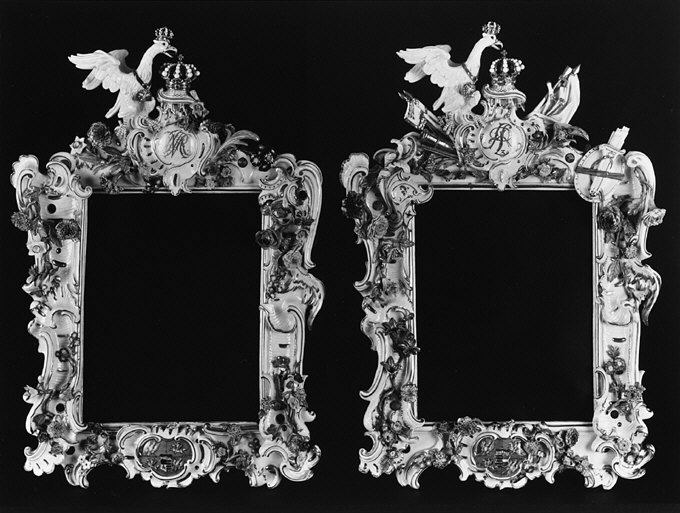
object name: mirror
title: Mirror (one of a pair)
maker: meissen manufactory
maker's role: manufactory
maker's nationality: german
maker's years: 1710-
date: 1750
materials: hard paste porcelain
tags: birds